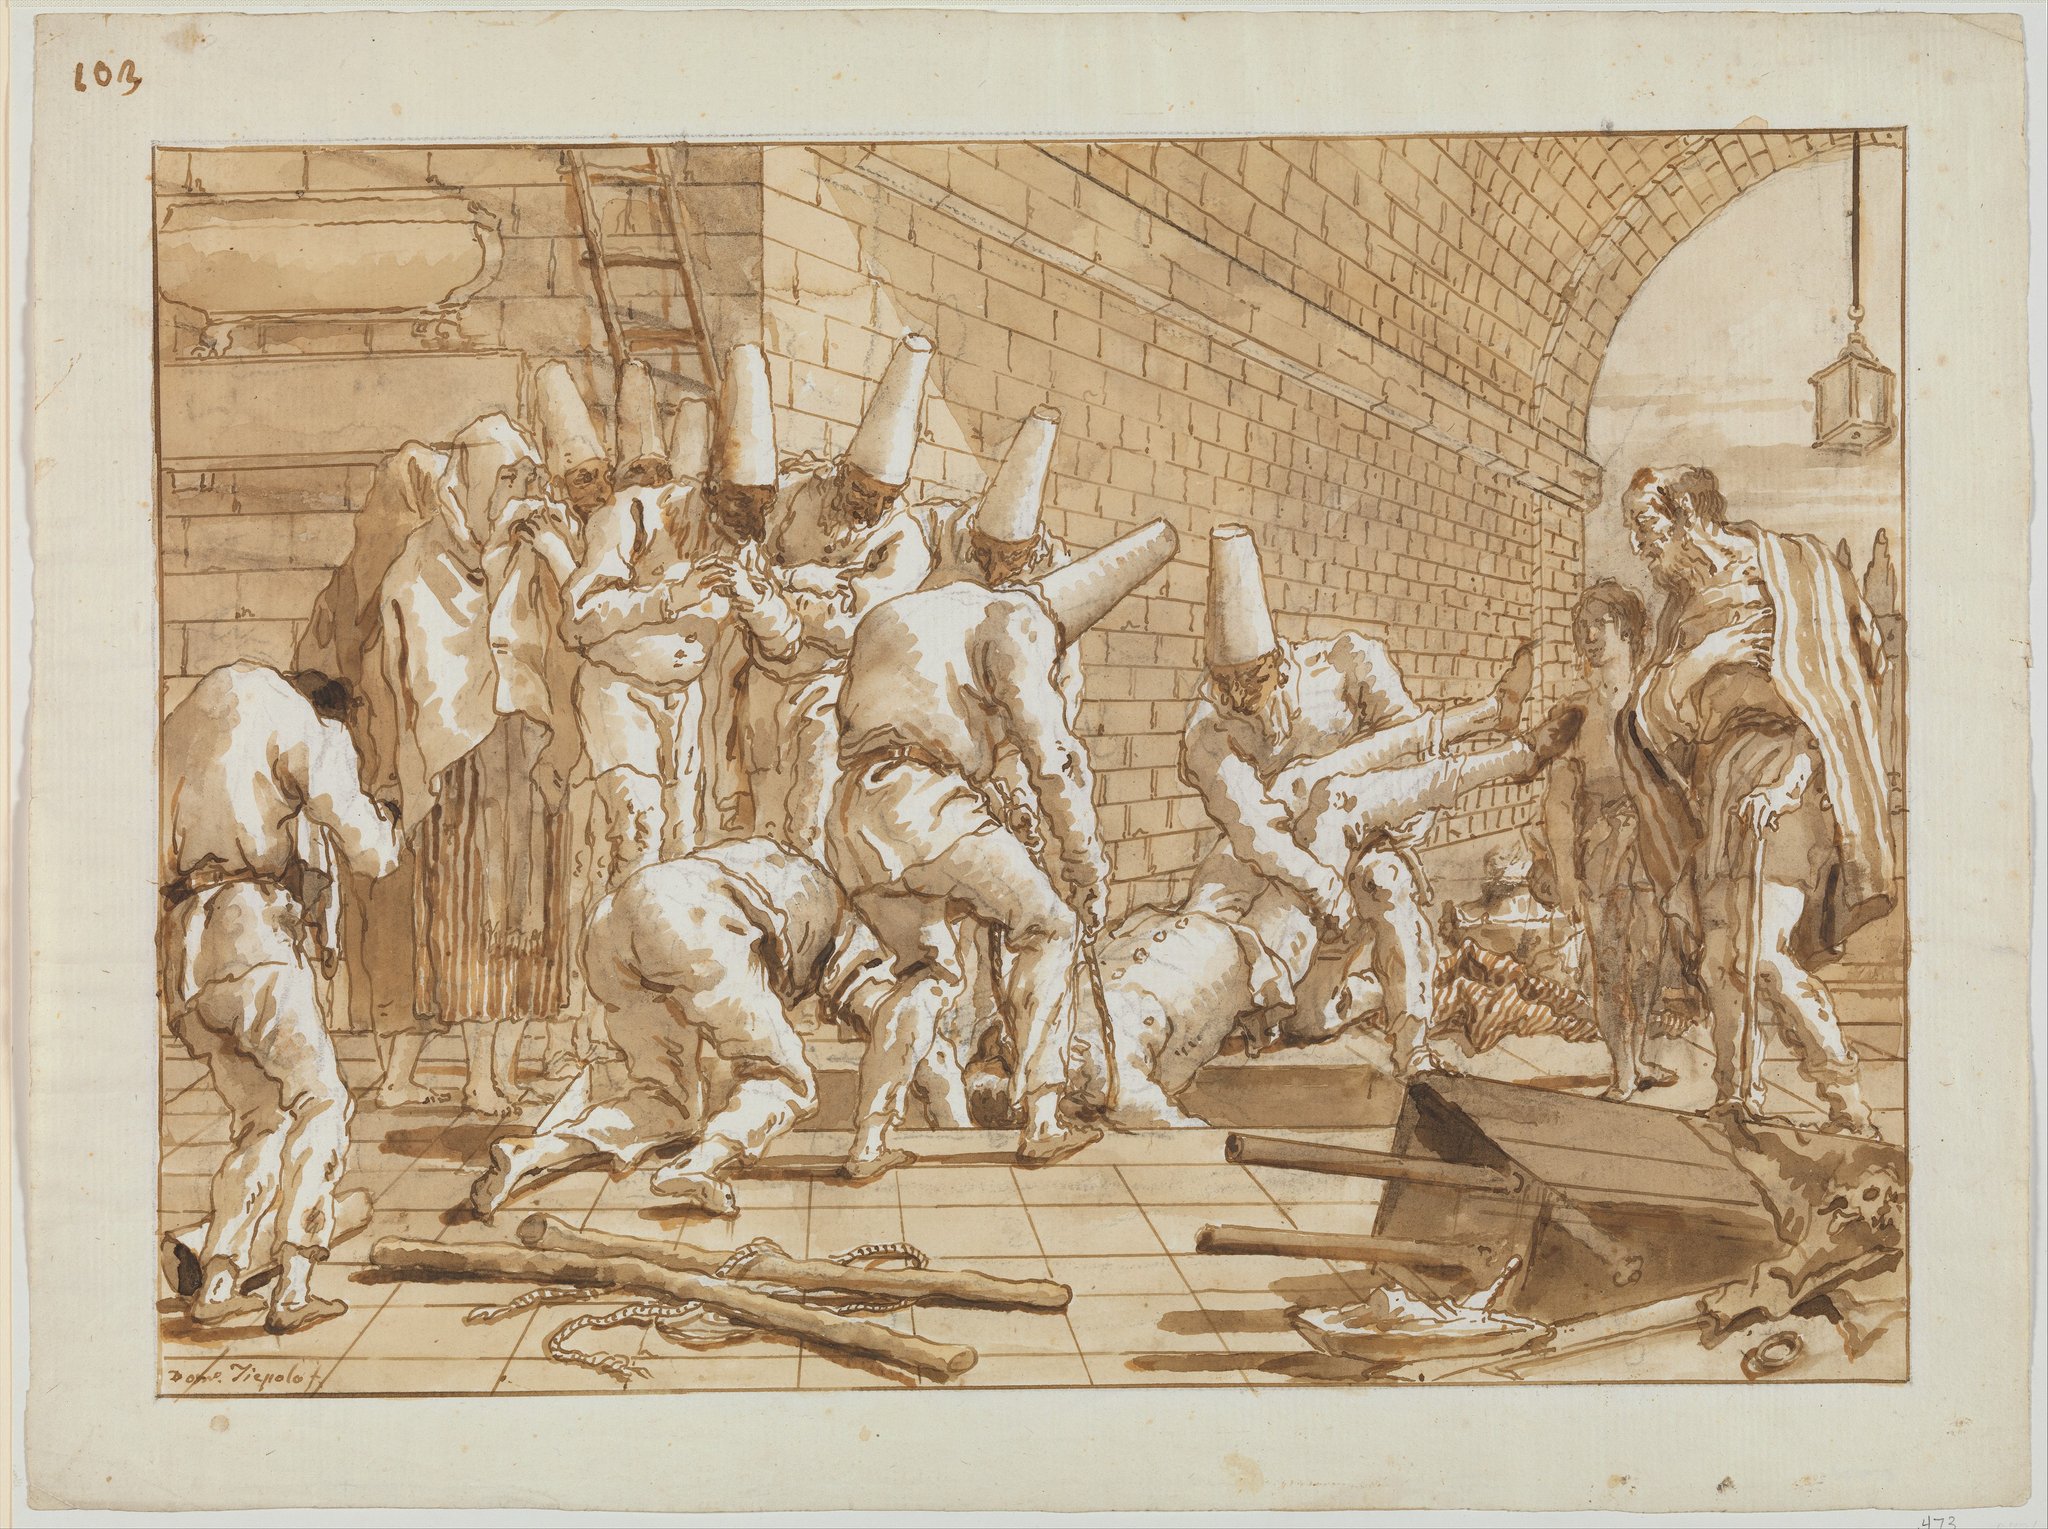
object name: drawing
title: The Burial of Punchinello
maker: giovanni domenico tiepolo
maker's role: artist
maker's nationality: italian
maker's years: 1727-1804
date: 1800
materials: chalk, ink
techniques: pen, wash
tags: sadness,men,burials,death